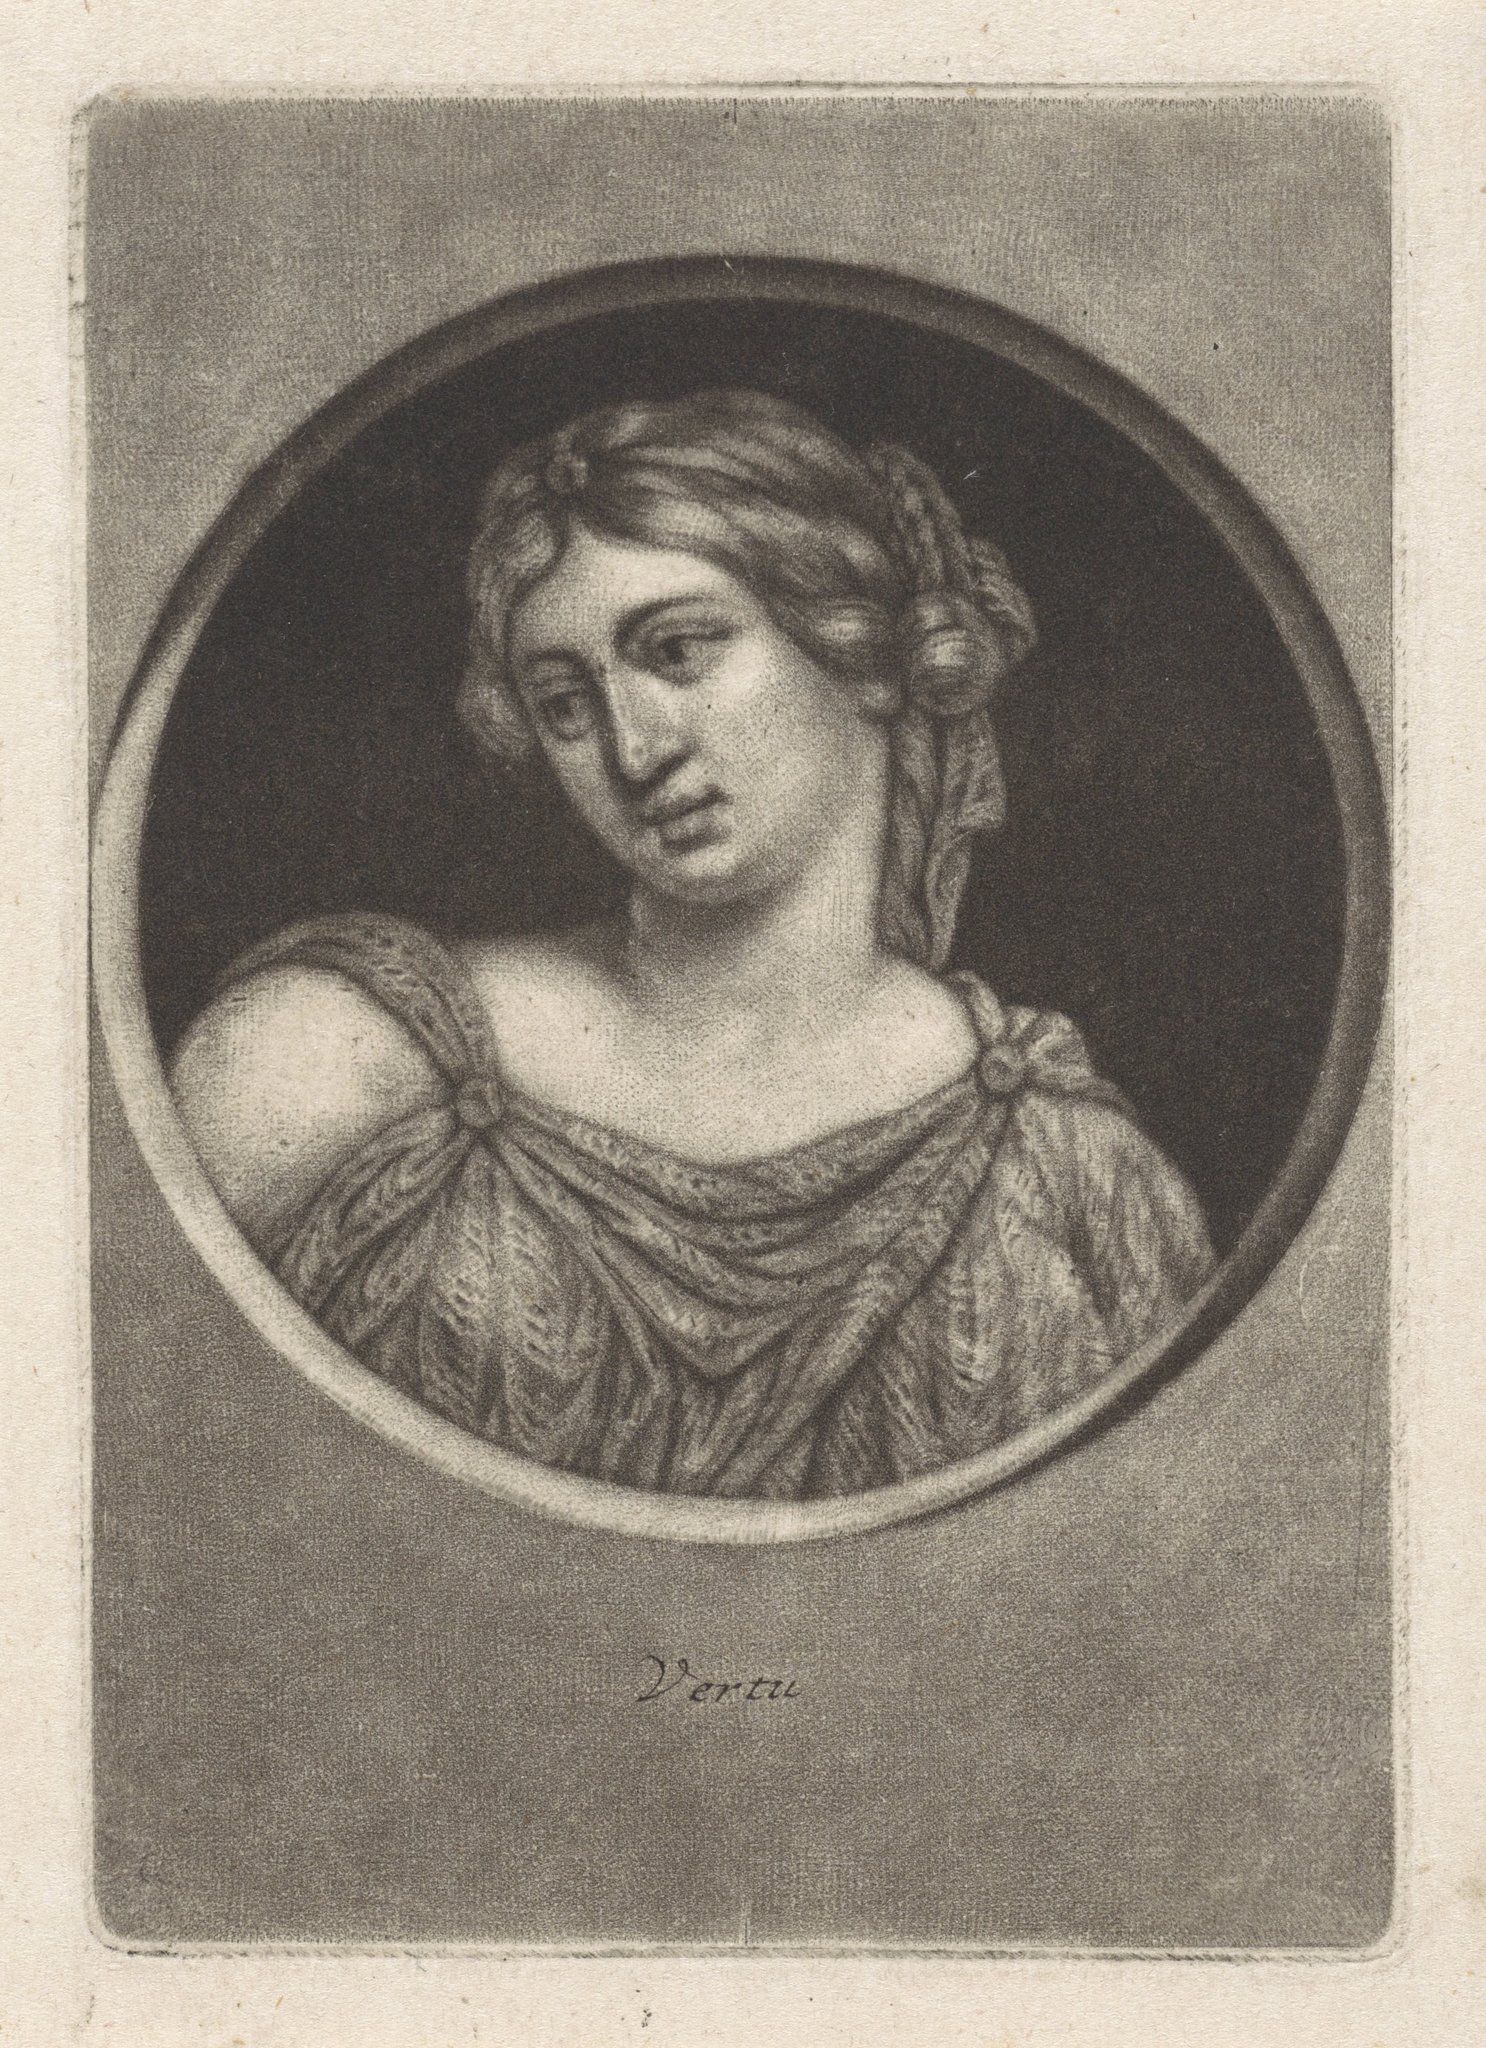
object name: print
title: Vertu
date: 1652-1690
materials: paper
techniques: engraving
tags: virtuousness; 'amor di virtù', 'attione virtuosa', 'guida sicura de' veri honori', 'virtù', 'virtù insuperabile' (ripa)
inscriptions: collector's mark: Lugt 2228